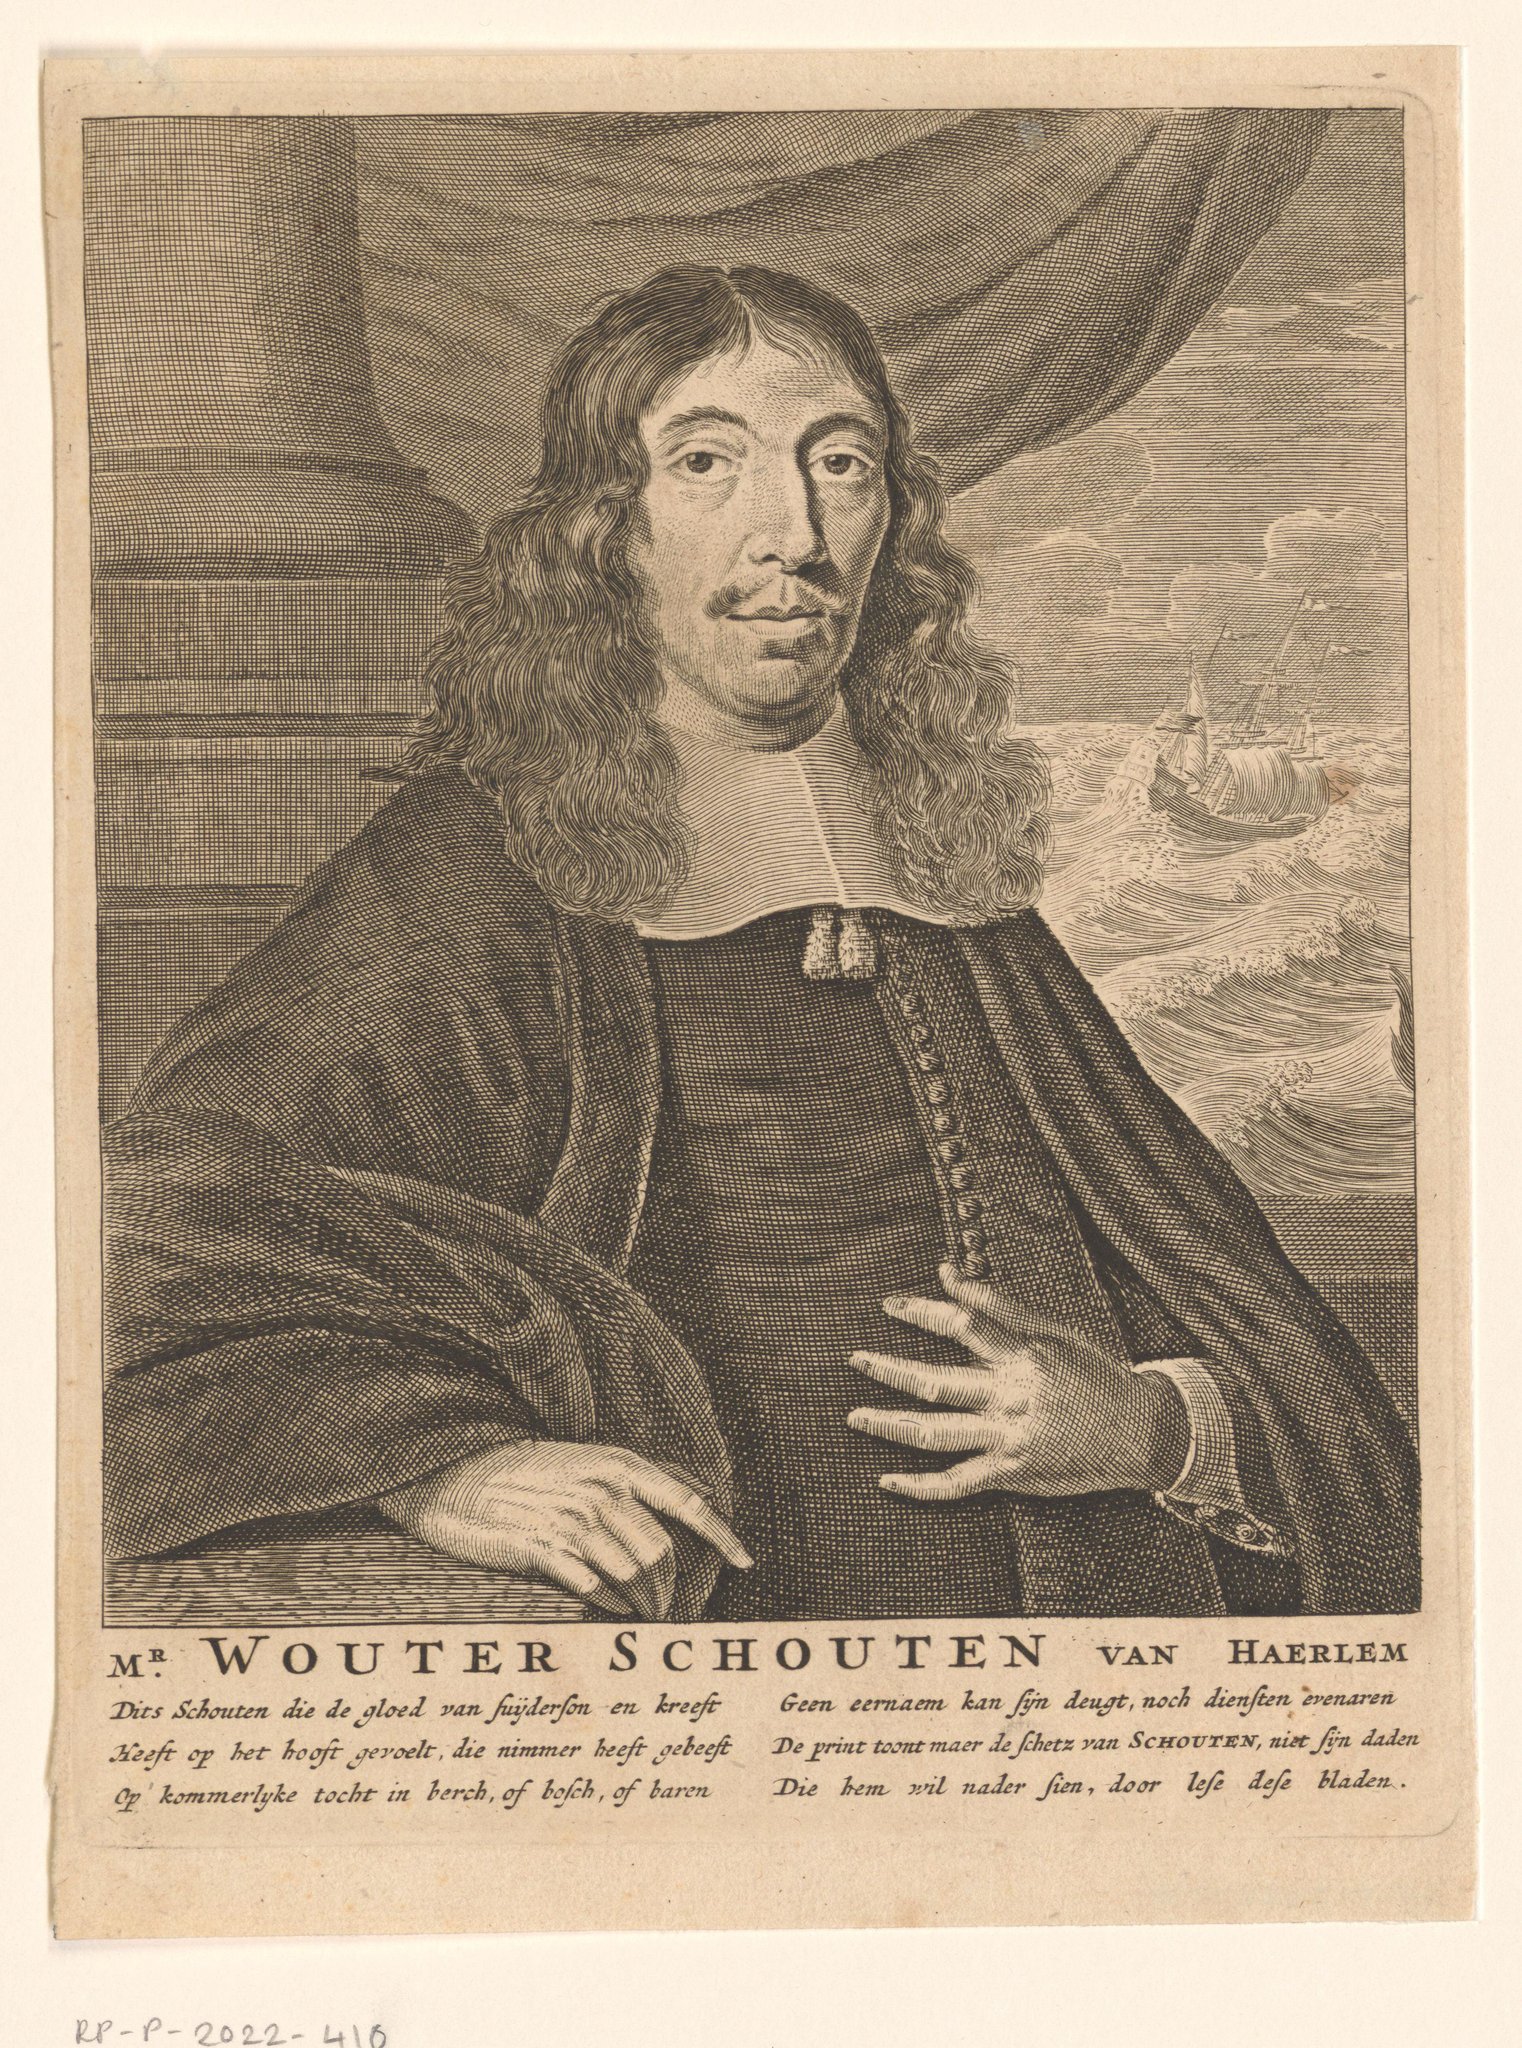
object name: print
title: Portret van Wouter Schouten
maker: christiaan hagen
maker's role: draughtsman, print maker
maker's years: 1635-1707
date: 1676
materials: paper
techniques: engraving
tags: haarlem, wouter schouten, historical persons, portrait of a writer, ships (in general), physician, doctor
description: Prent waarschijnlijk: Schouten, Wouter. Oost-Indische voyagie (...). Amsterdam: Jacob Meurs, 1676.